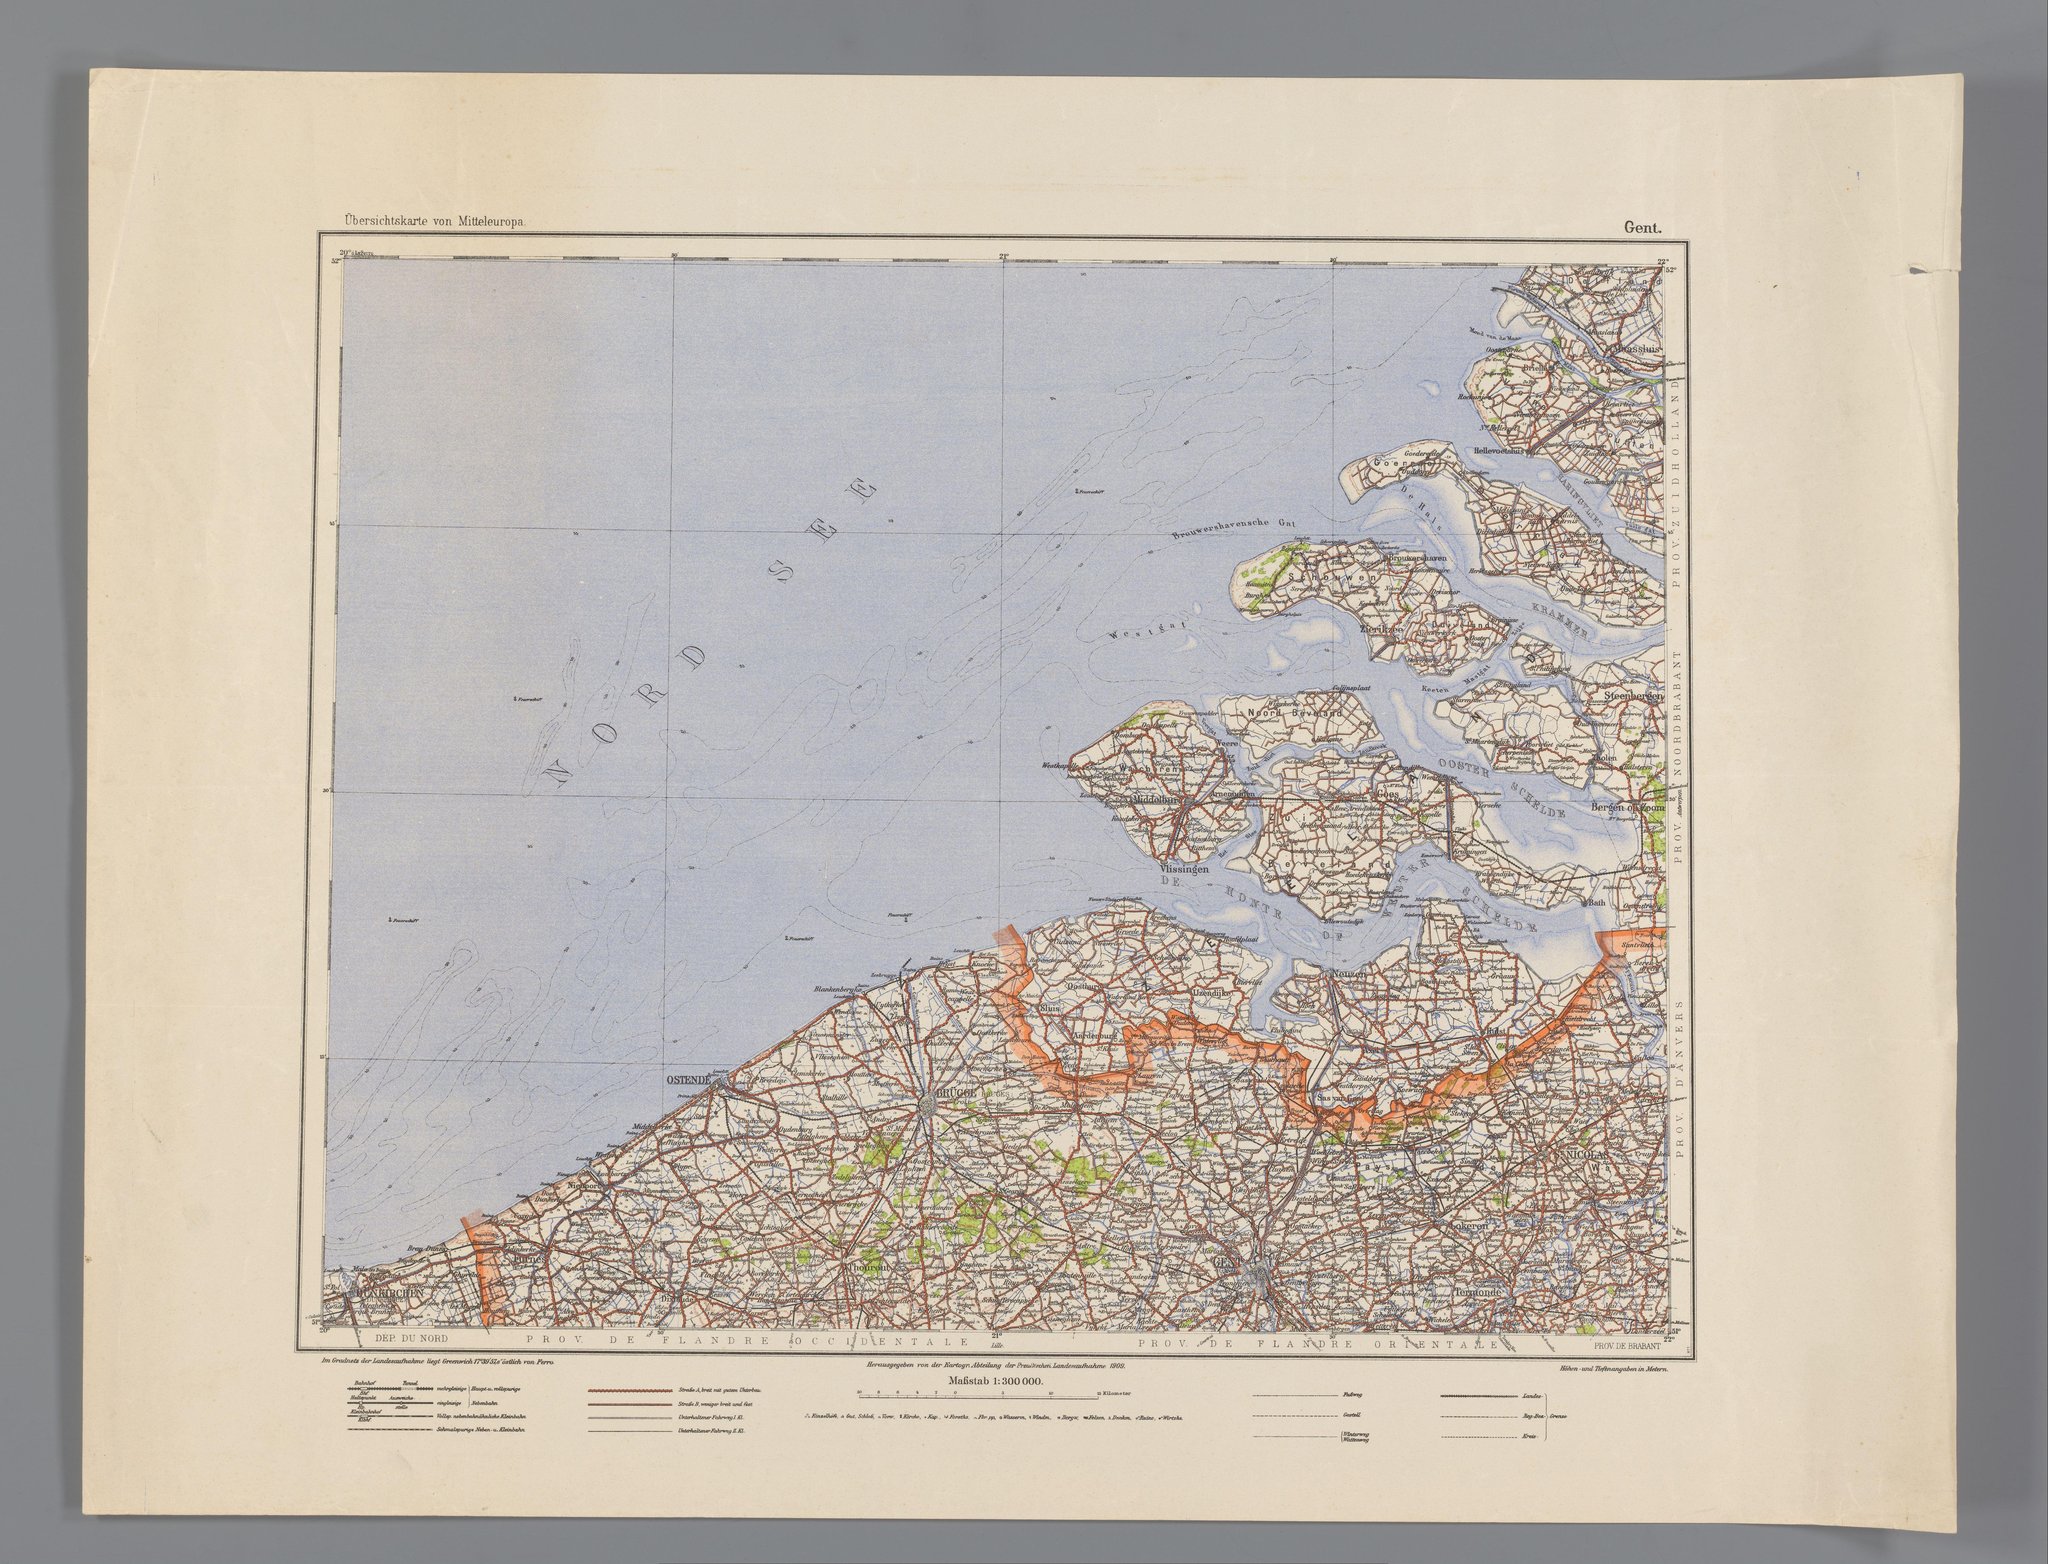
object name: print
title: Übersichtskarte von Mitteleuropa. Gent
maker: Anonymous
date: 1909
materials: paper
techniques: lithograph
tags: maps of separate countries or regions, zeeland, ghent, bruges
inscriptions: date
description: Kaart van Zeeland en een gedeelte van West-Vlaanderen en Oost-Vlaanderen.